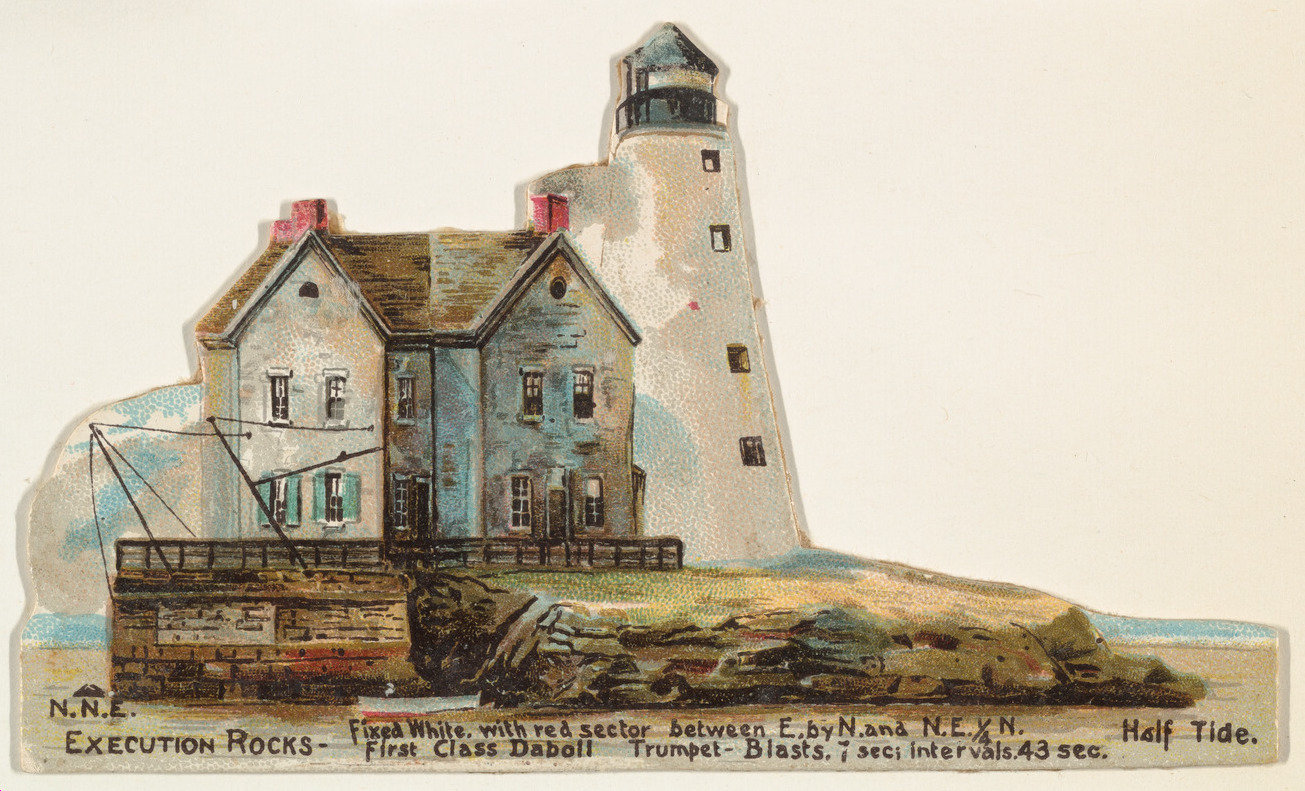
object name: print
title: Execution Rocks, from the Lighthouses series (N119) issued by Duke Sons & Co. to promote Honest Long Cut Tobacco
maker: w. duke, sons & co.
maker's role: publisher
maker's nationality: american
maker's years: 1870-1920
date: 1889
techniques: color lithograph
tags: lighthouses